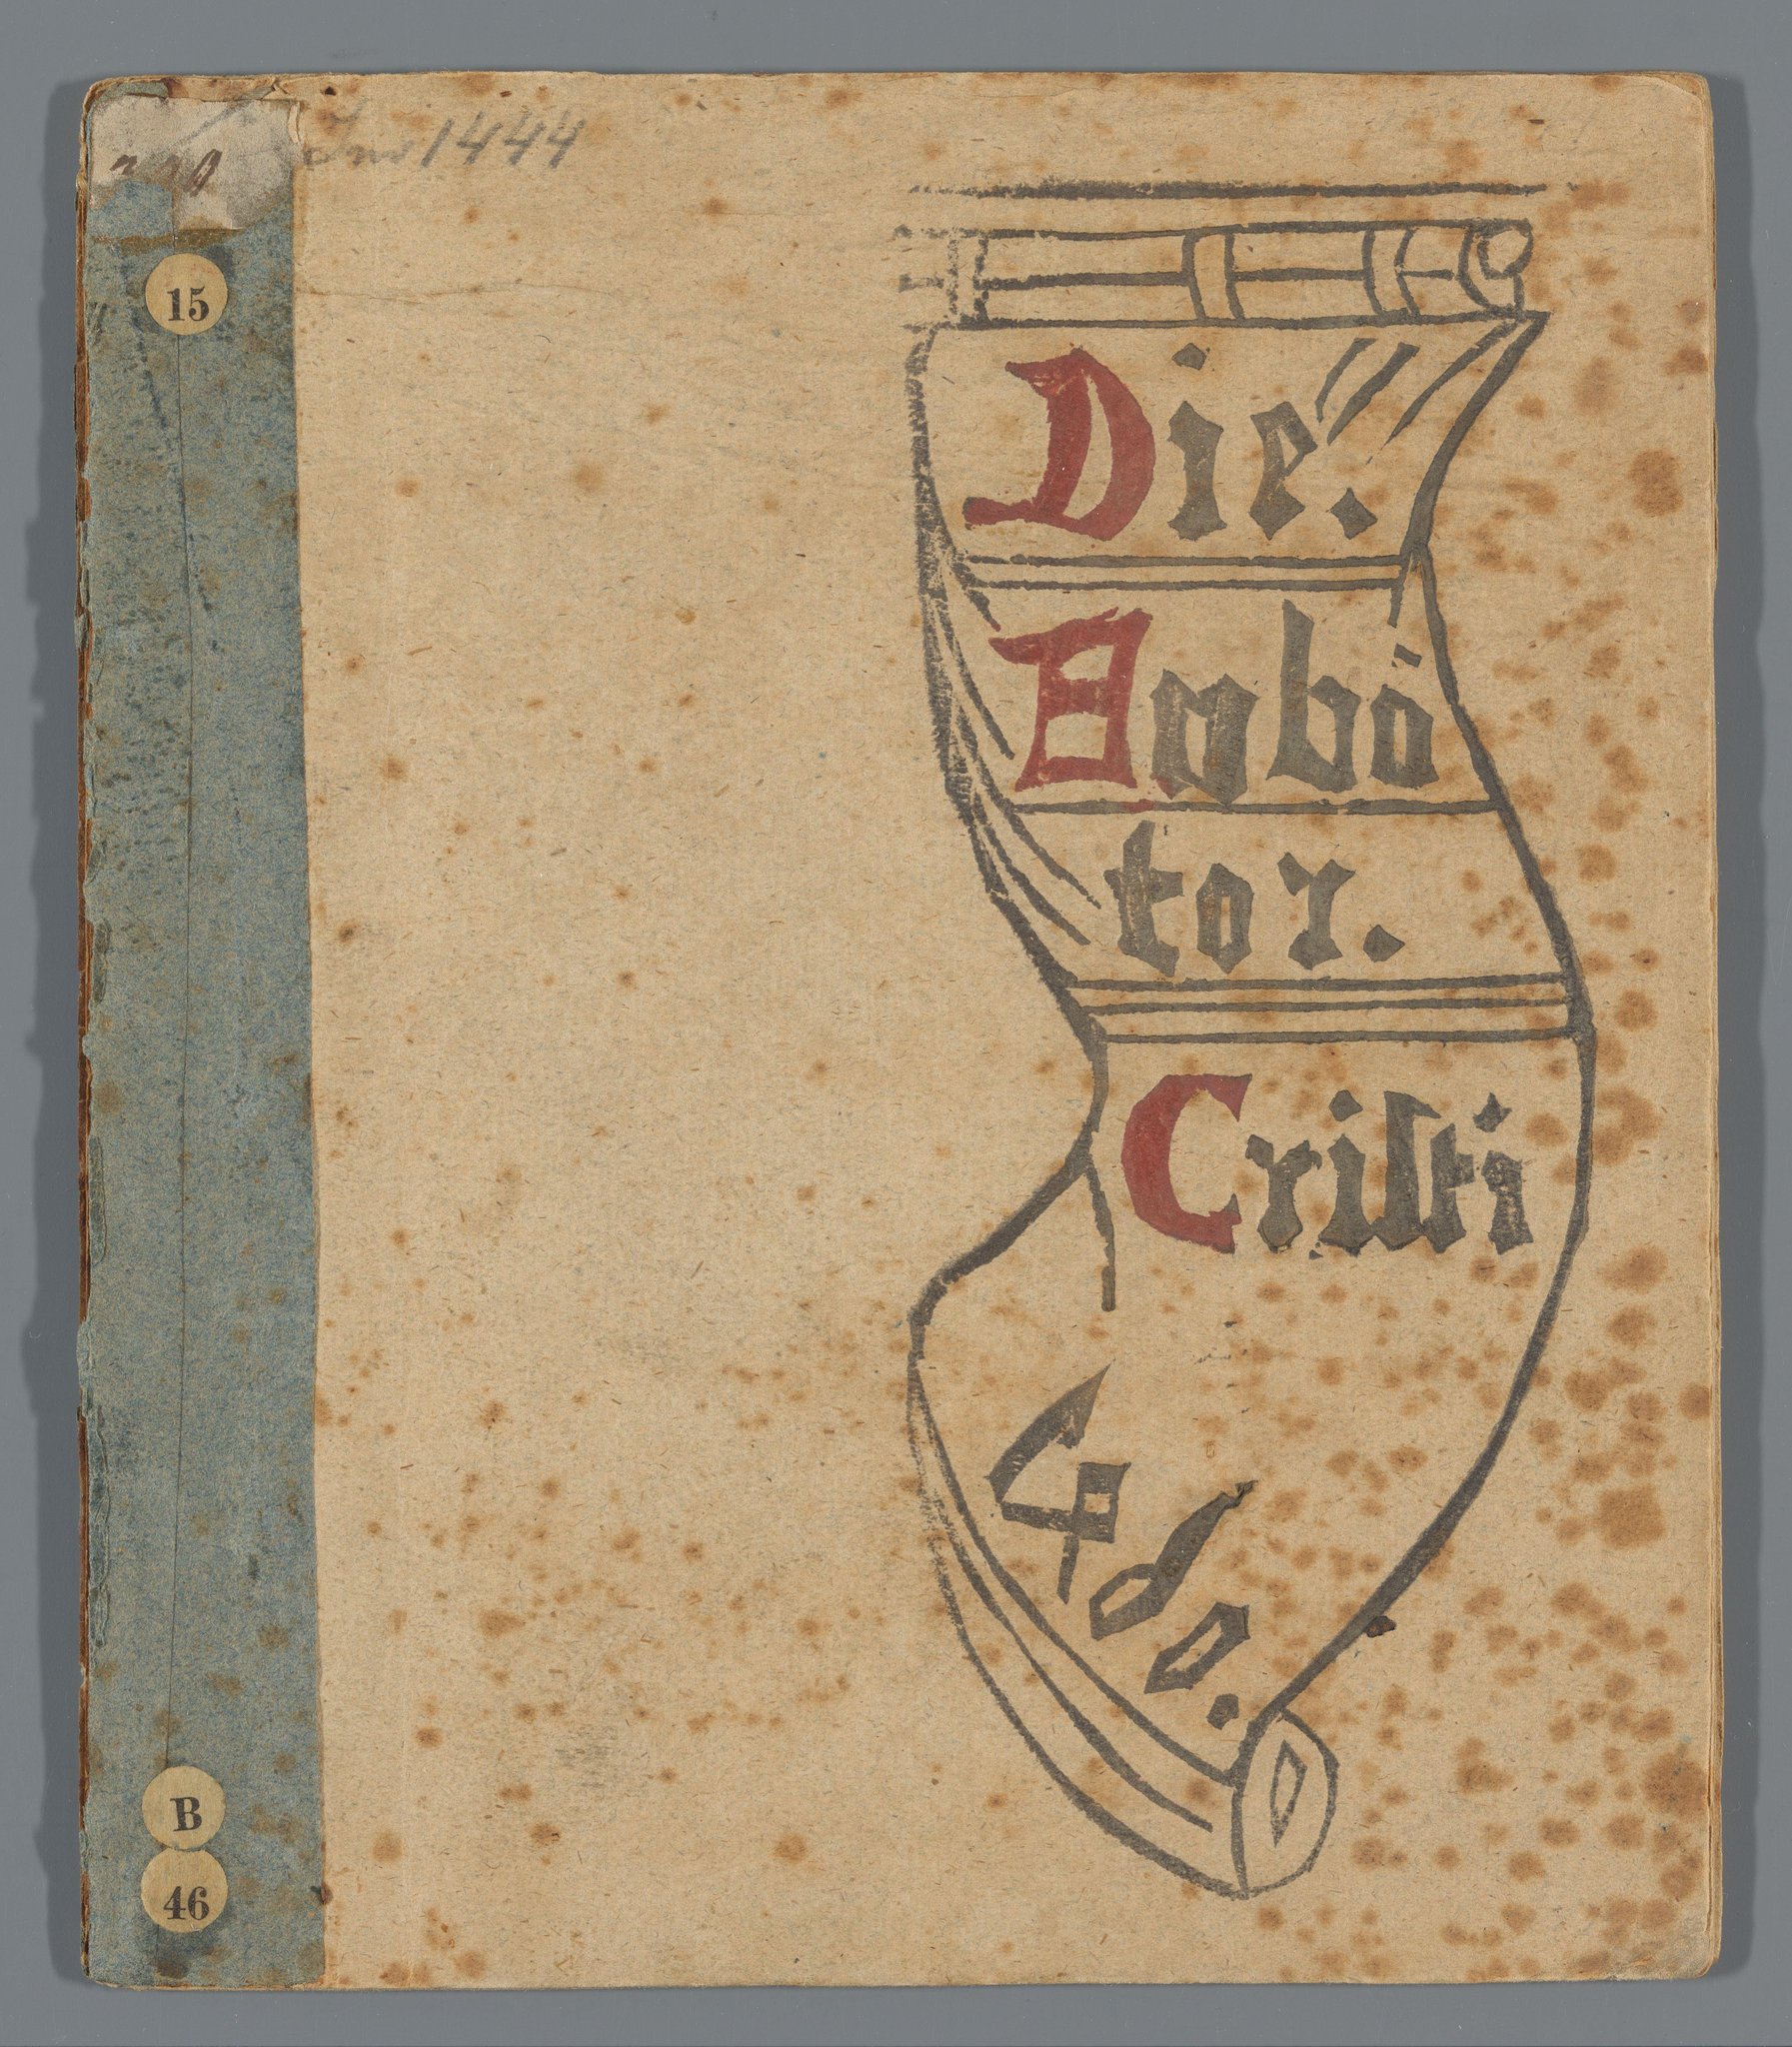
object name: album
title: Titelpagina voor een serie heiligen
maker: Anonymous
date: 1800-1899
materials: paper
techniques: woodcut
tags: saints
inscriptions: collector's mark: Lugt 2166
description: Album met negen voorstellingen van heiligen naar voorbeeld van een boek uit 1460.